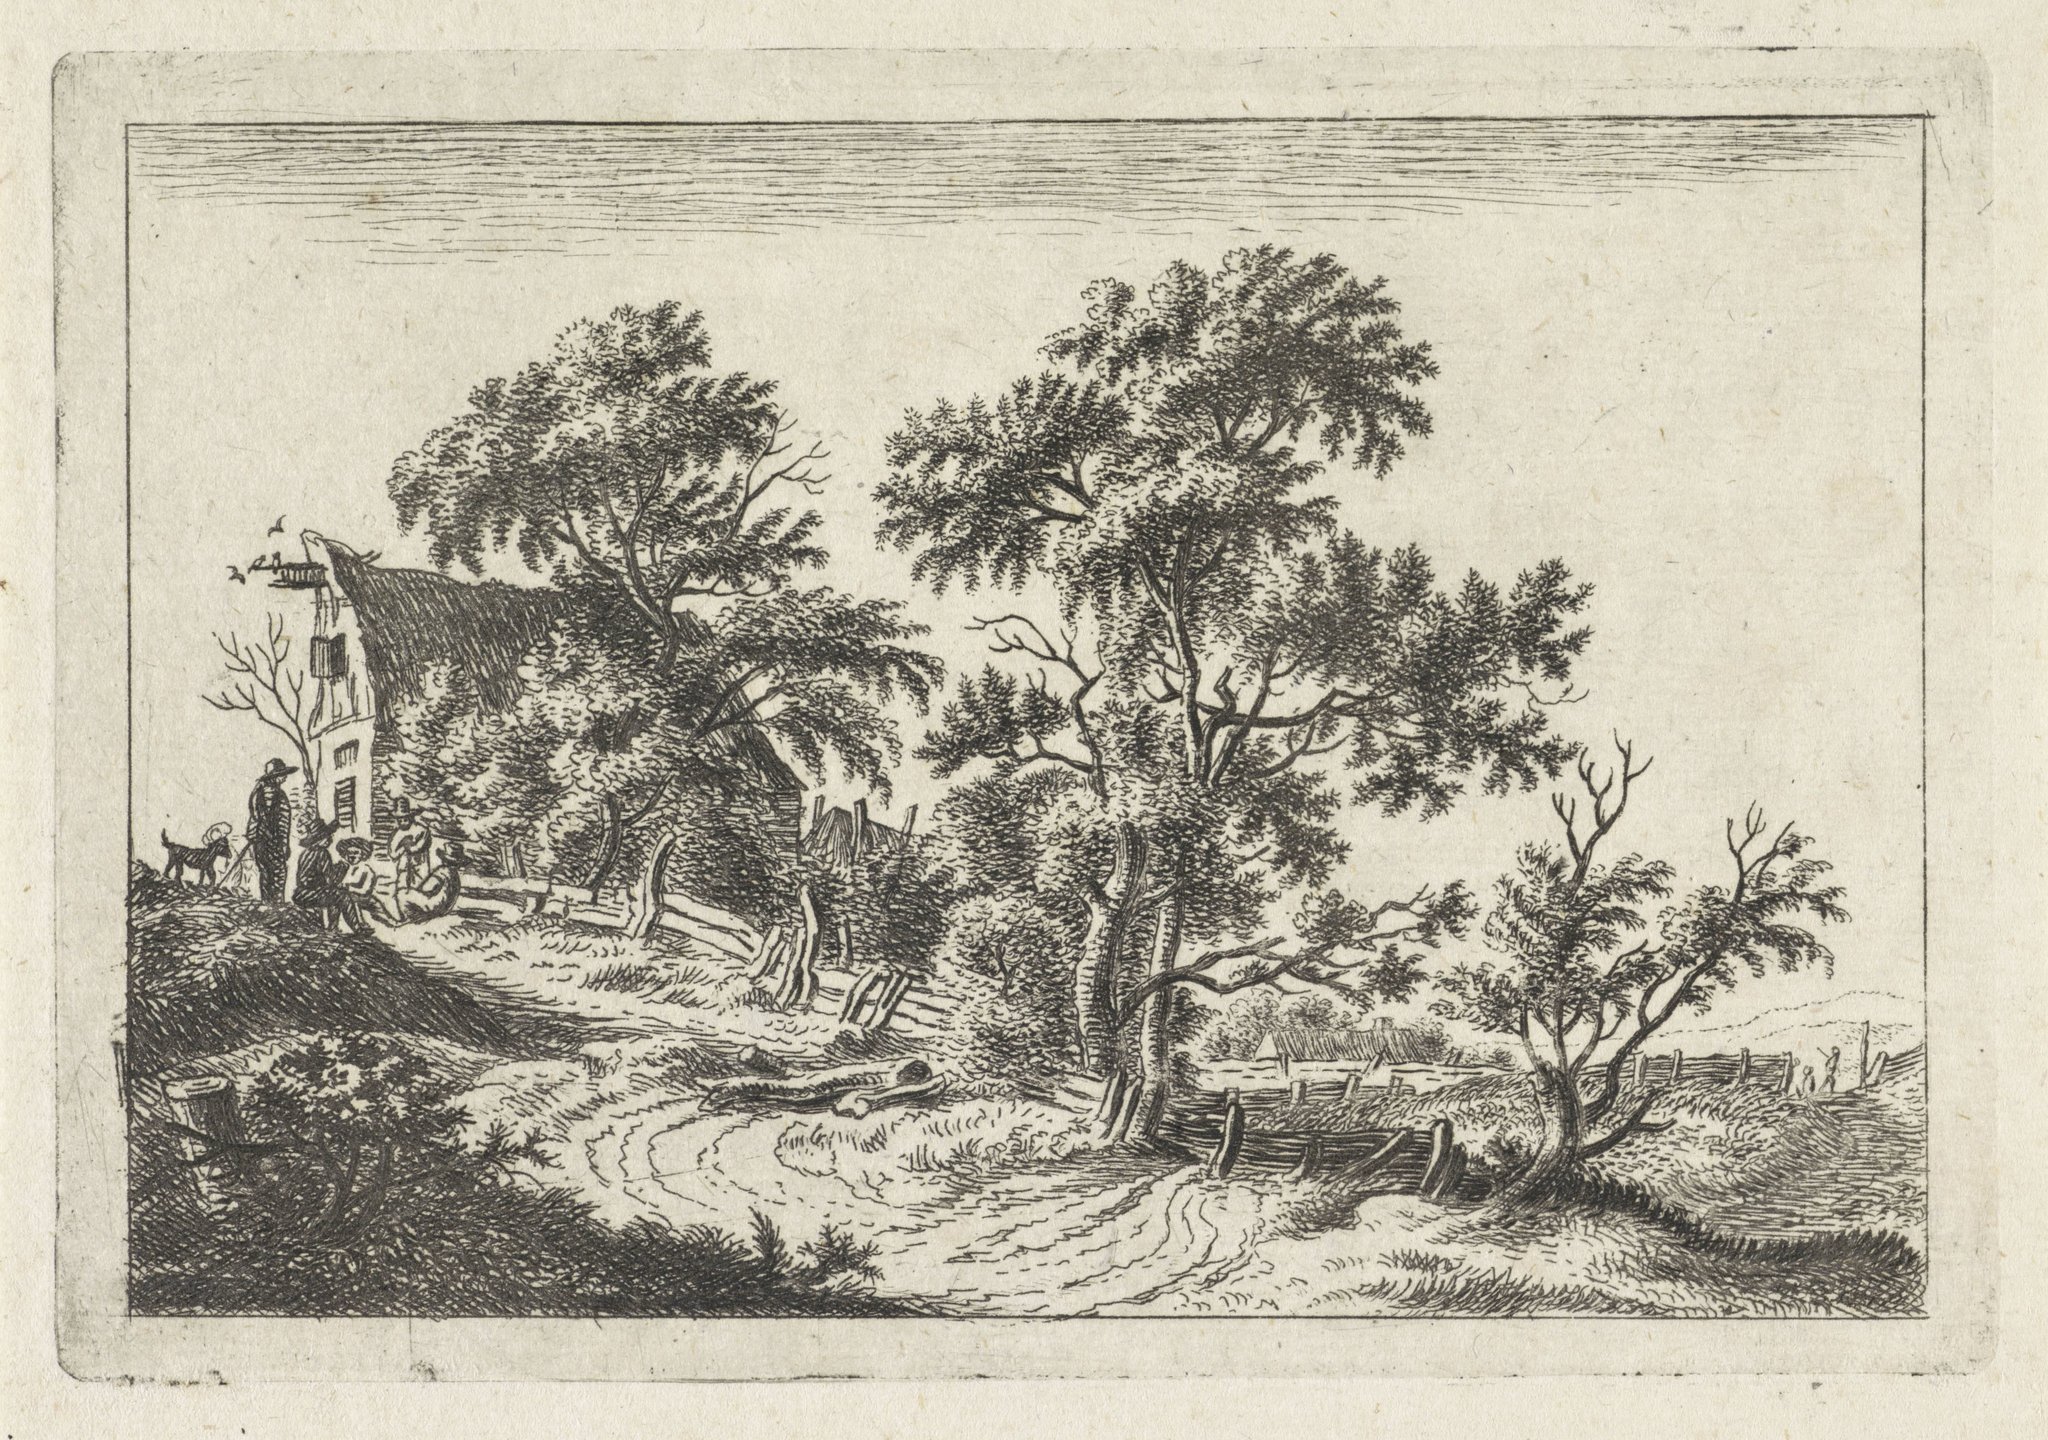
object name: print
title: Huis aan een pad op een heuvel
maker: Anonymous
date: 1630-1740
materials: paper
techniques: etching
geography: amsterdam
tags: low hill country, 'en route', traveller under way, farm or solitary house in landscape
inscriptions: collector's mark: Lugt 2228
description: Links staat een huis op een heuvel aan een pad. Tegenover het huis rusten enkele figuren.